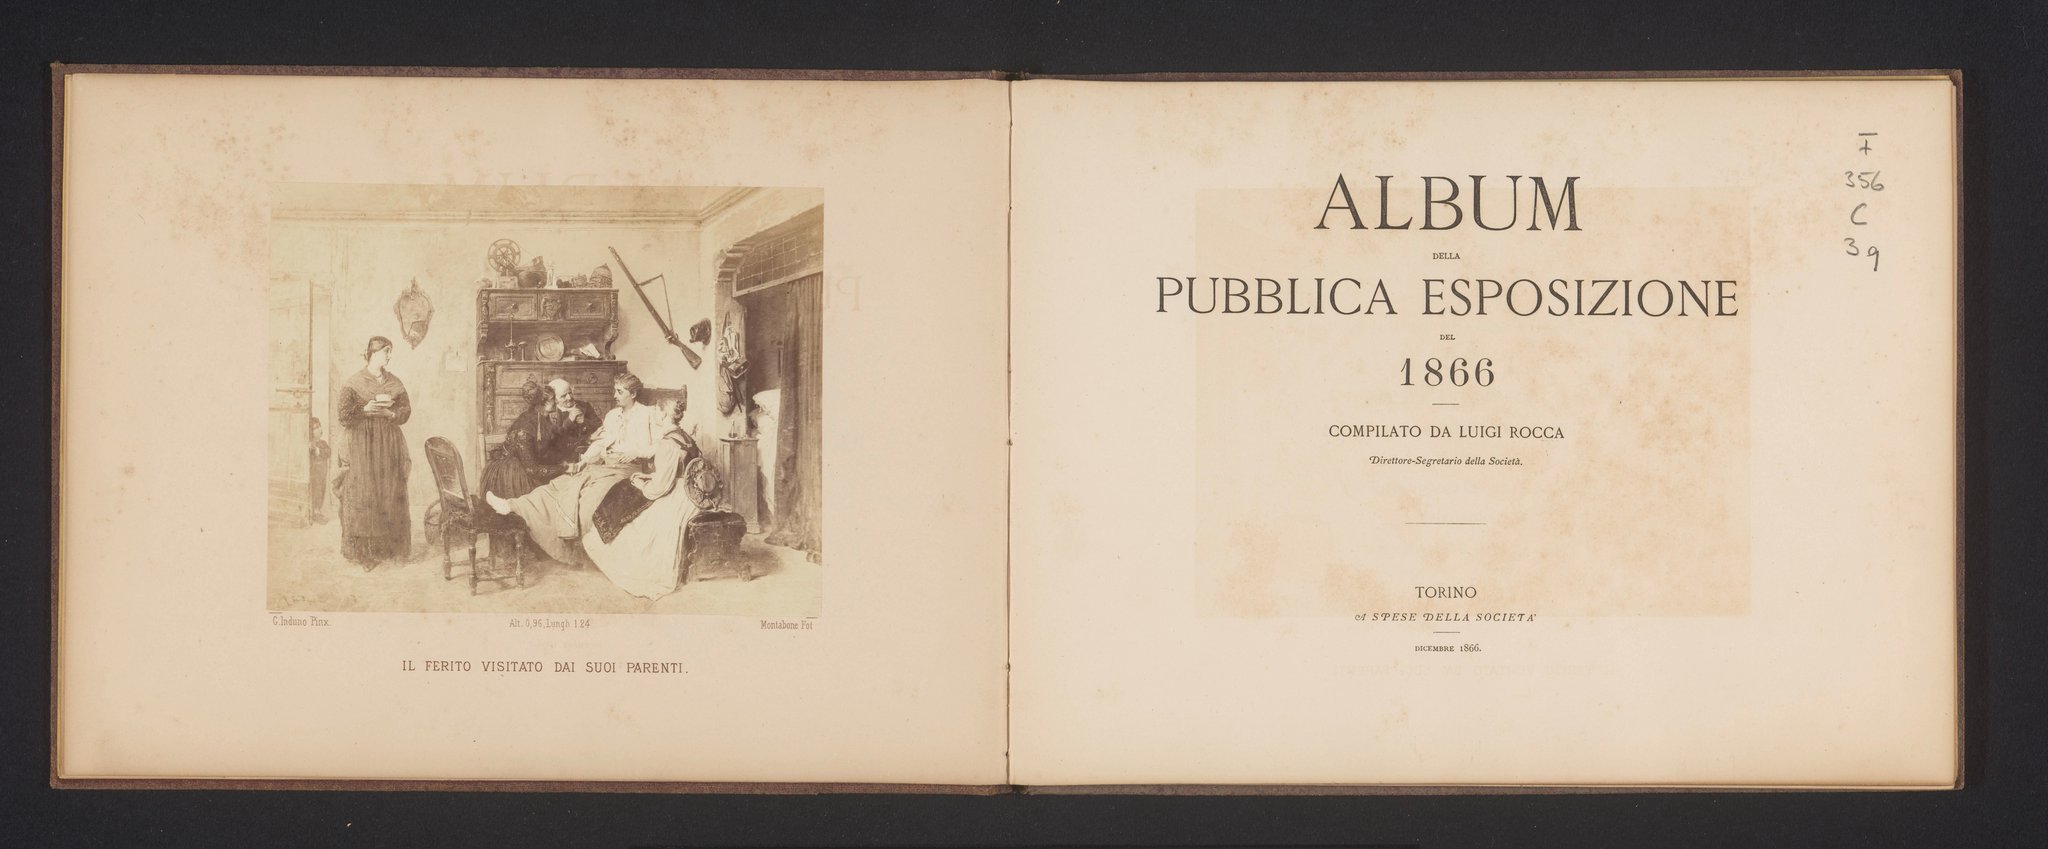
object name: reproduction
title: Fotoreproductie van een schilderij, voorstellende een gewonde man wordt bezocht door zijn familie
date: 1865-1866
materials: photographic support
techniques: albumen print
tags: medical aid and nursing of the sick and wounded, interior ~ representation of a building, family relationships (first, second, third and fourth degree), generations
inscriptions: inscription: ‘Alt. 0,96, Lungh, 1.24’